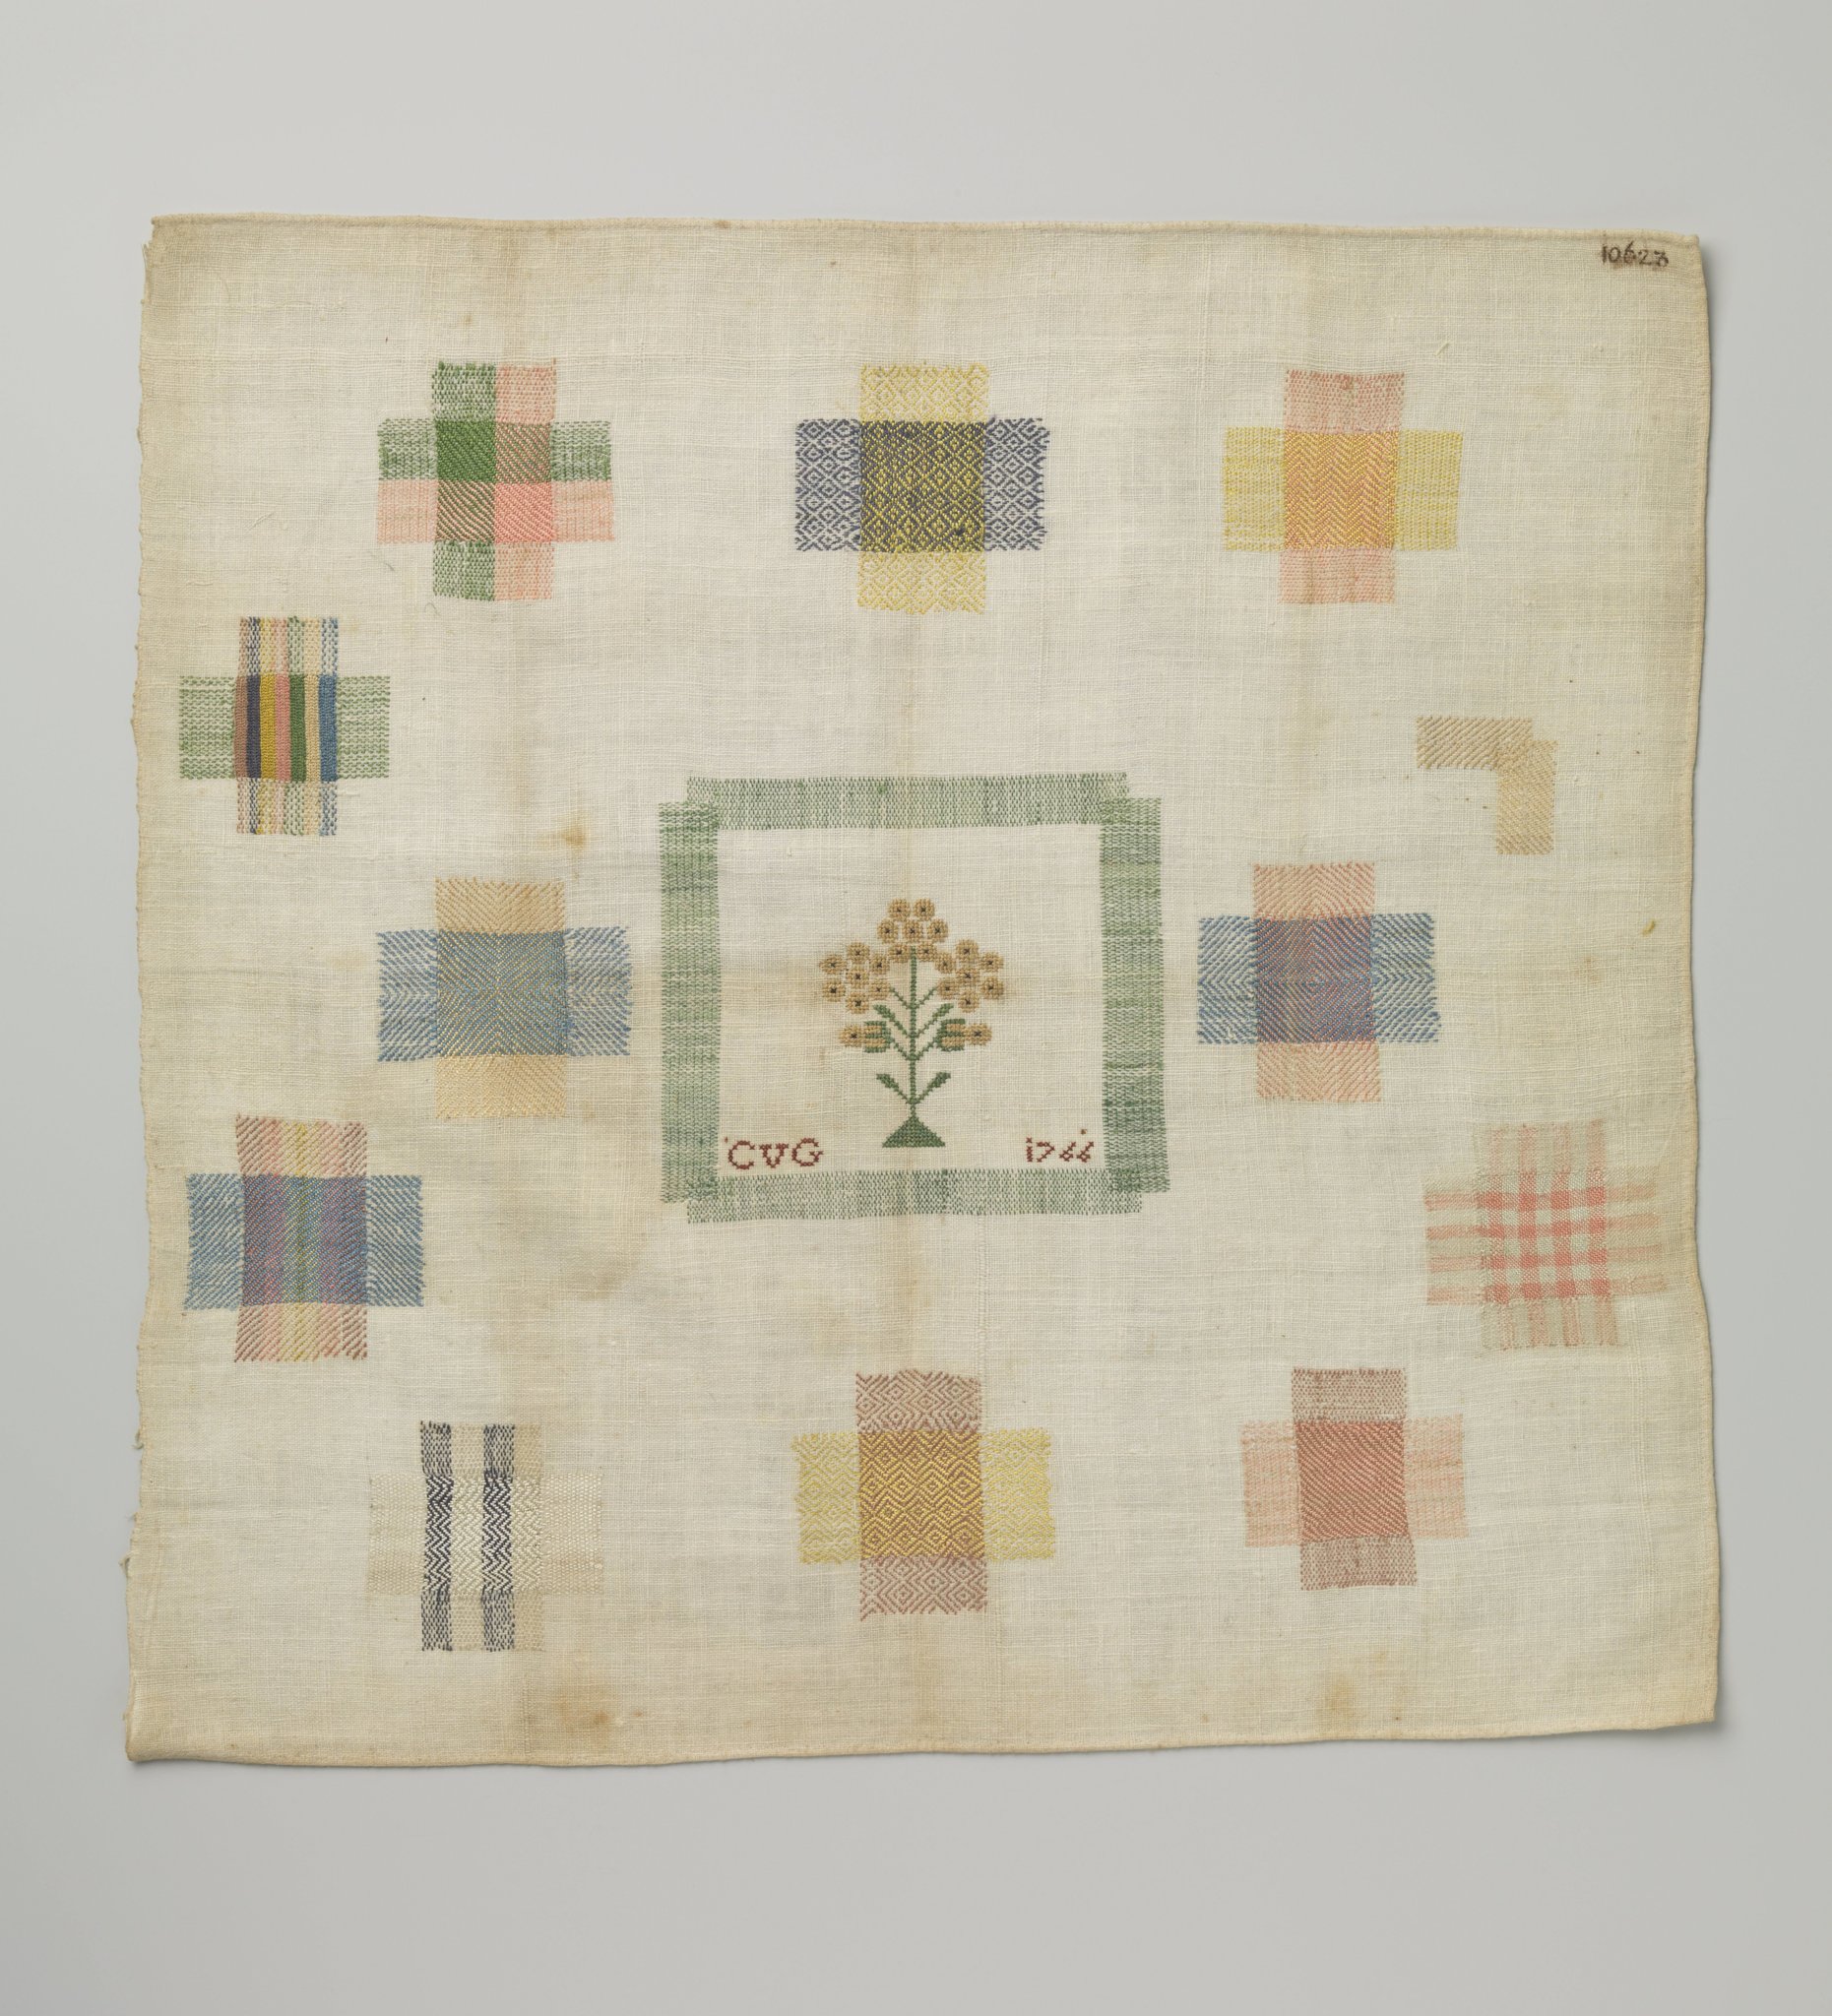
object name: stoplap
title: Stoplap van veelkleurige zijde op katoenen mousseline.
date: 1766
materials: cotton, silk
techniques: embroidered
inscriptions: date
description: Stoplap met borduurwerk. Het borduurwerk bestaat uit de initialen CVG, het jaartal 1766 en in het midden een vierkant waarbinnen een bloem.